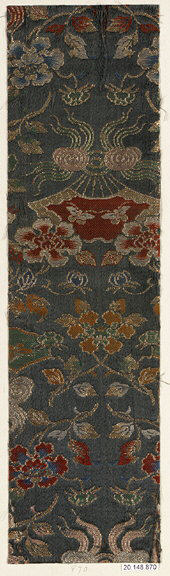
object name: piece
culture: japanese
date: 1701-1800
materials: silk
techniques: compound weave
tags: flowers,leaves